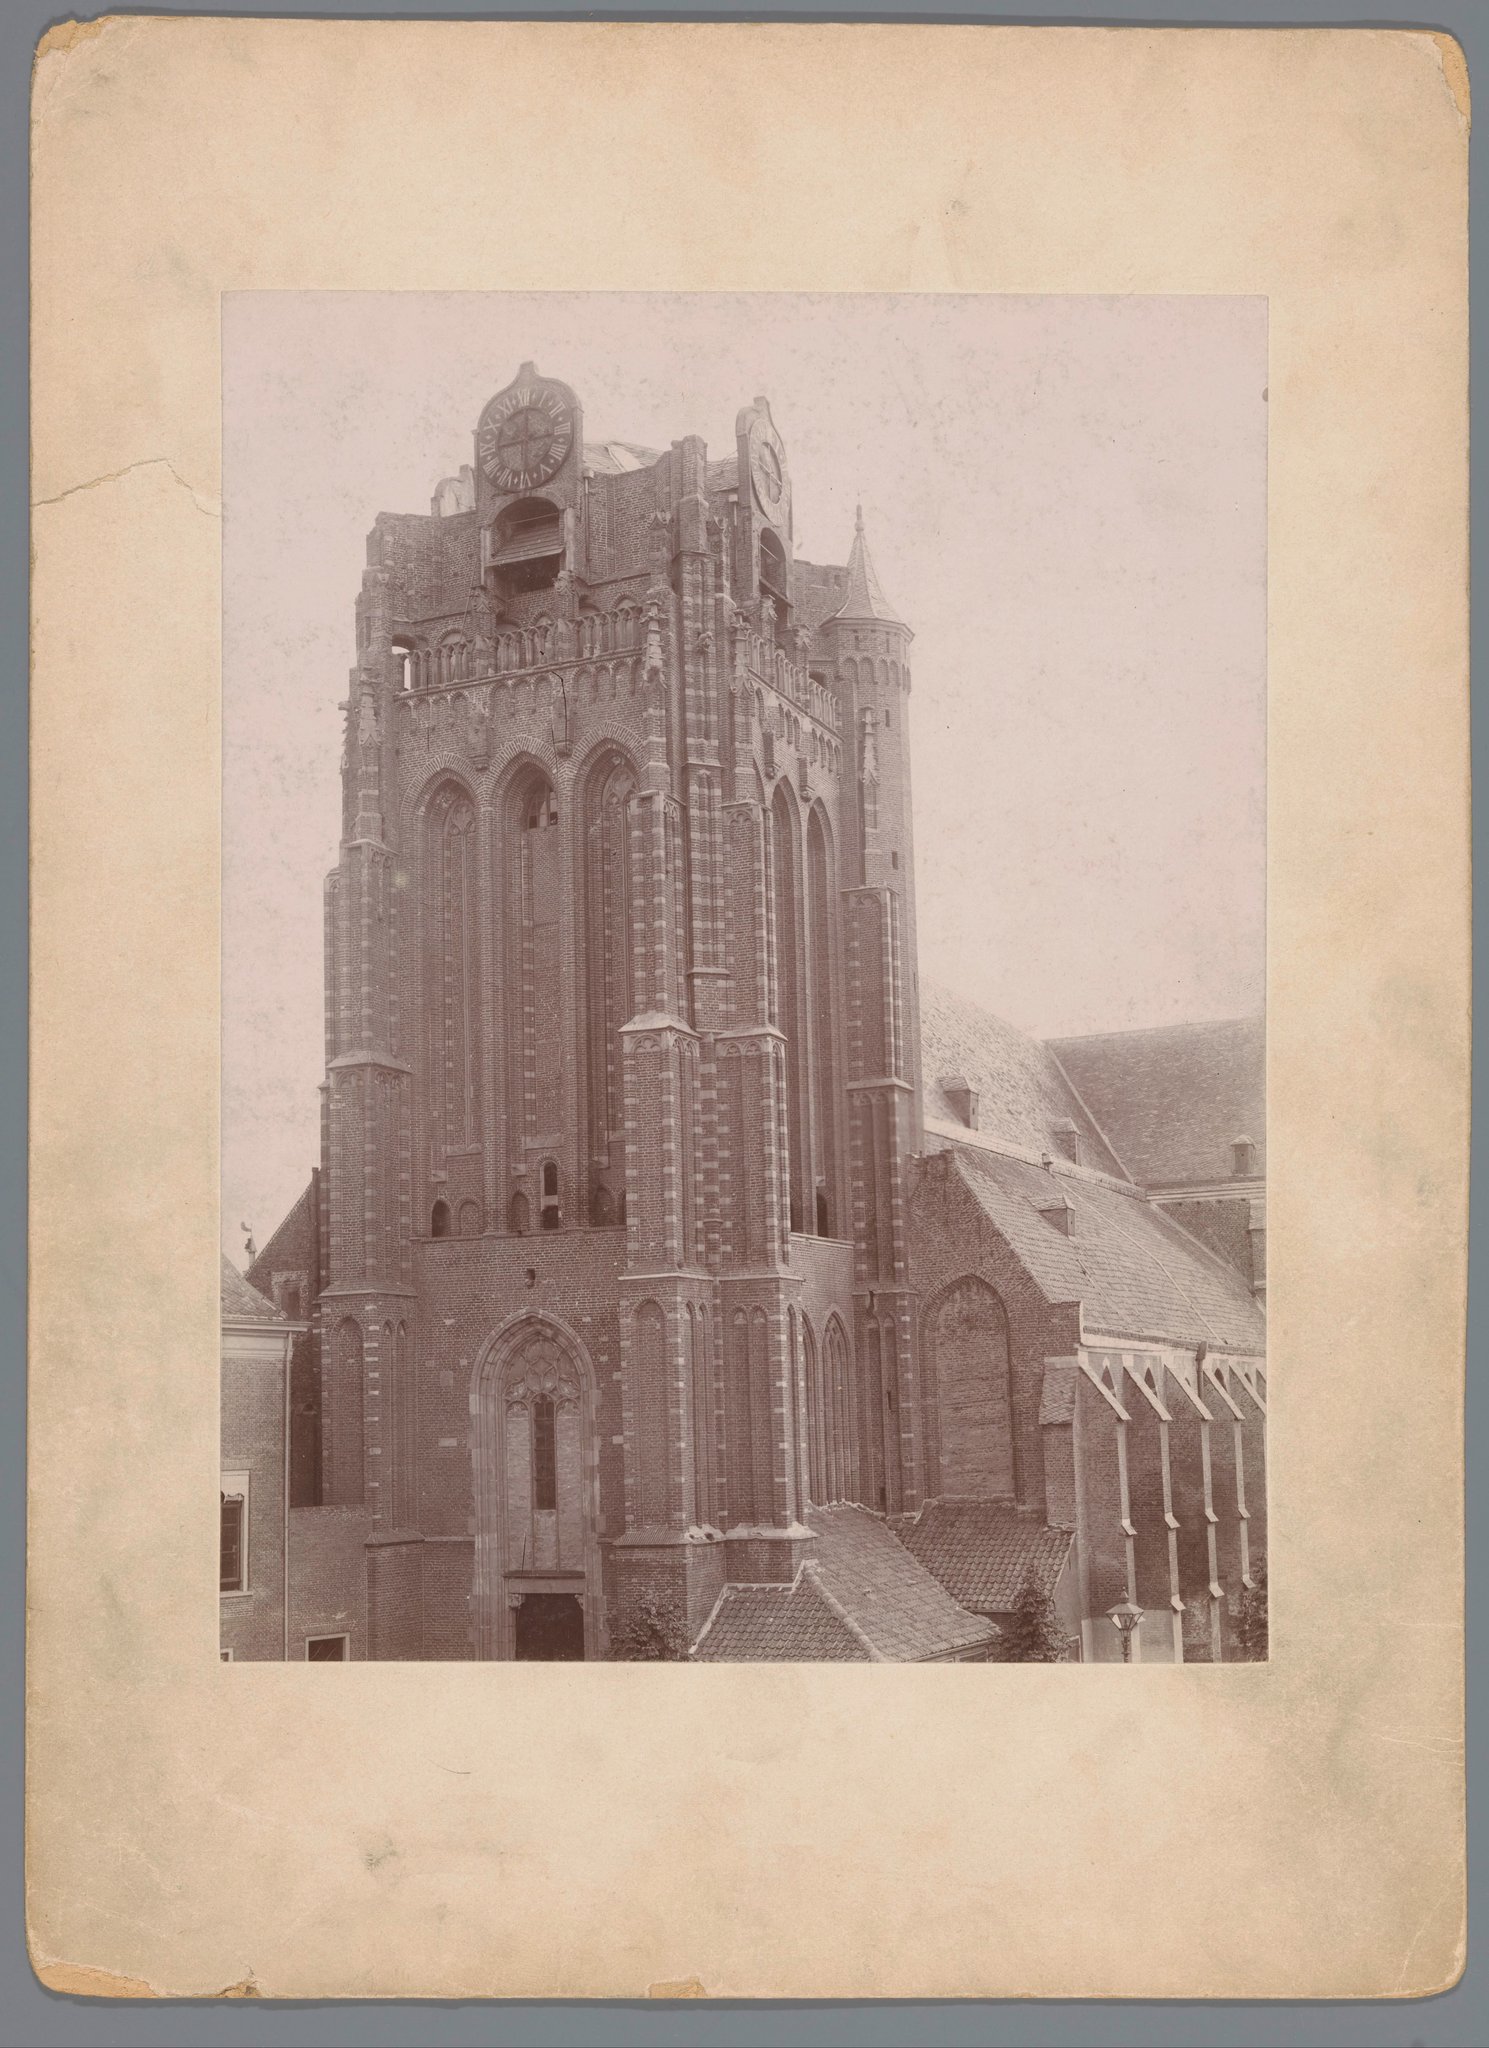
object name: photograph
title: Toren van de Johannes de Doperkerk te Wijk bij Duurstede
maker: Anonymous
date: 1875-1900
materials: cardboard, photographic support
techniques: daylight paper print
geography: grote of johannes de doperkerk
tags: tower, clock tower ~ monumental adornment, parts of church exterior and annexes: tower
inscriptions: collector's mark: Lugt 3937, inscription: ‘Toren te Wijk-bij-duurstede’